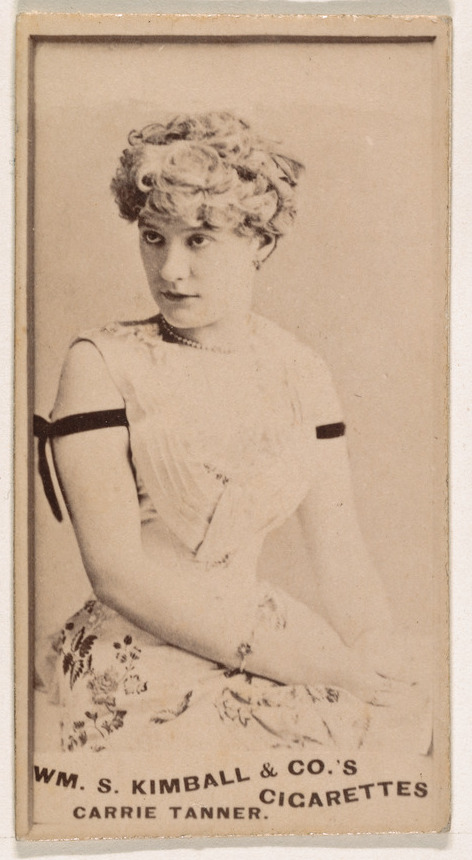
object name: photograph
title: Carrie Tanner, from the Actresses series (N203) issued by Wm. S. Kimball & Co.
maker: william s. kimball & company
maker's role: publisher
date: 1889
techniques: color lithograph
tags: portraits,women,actresses